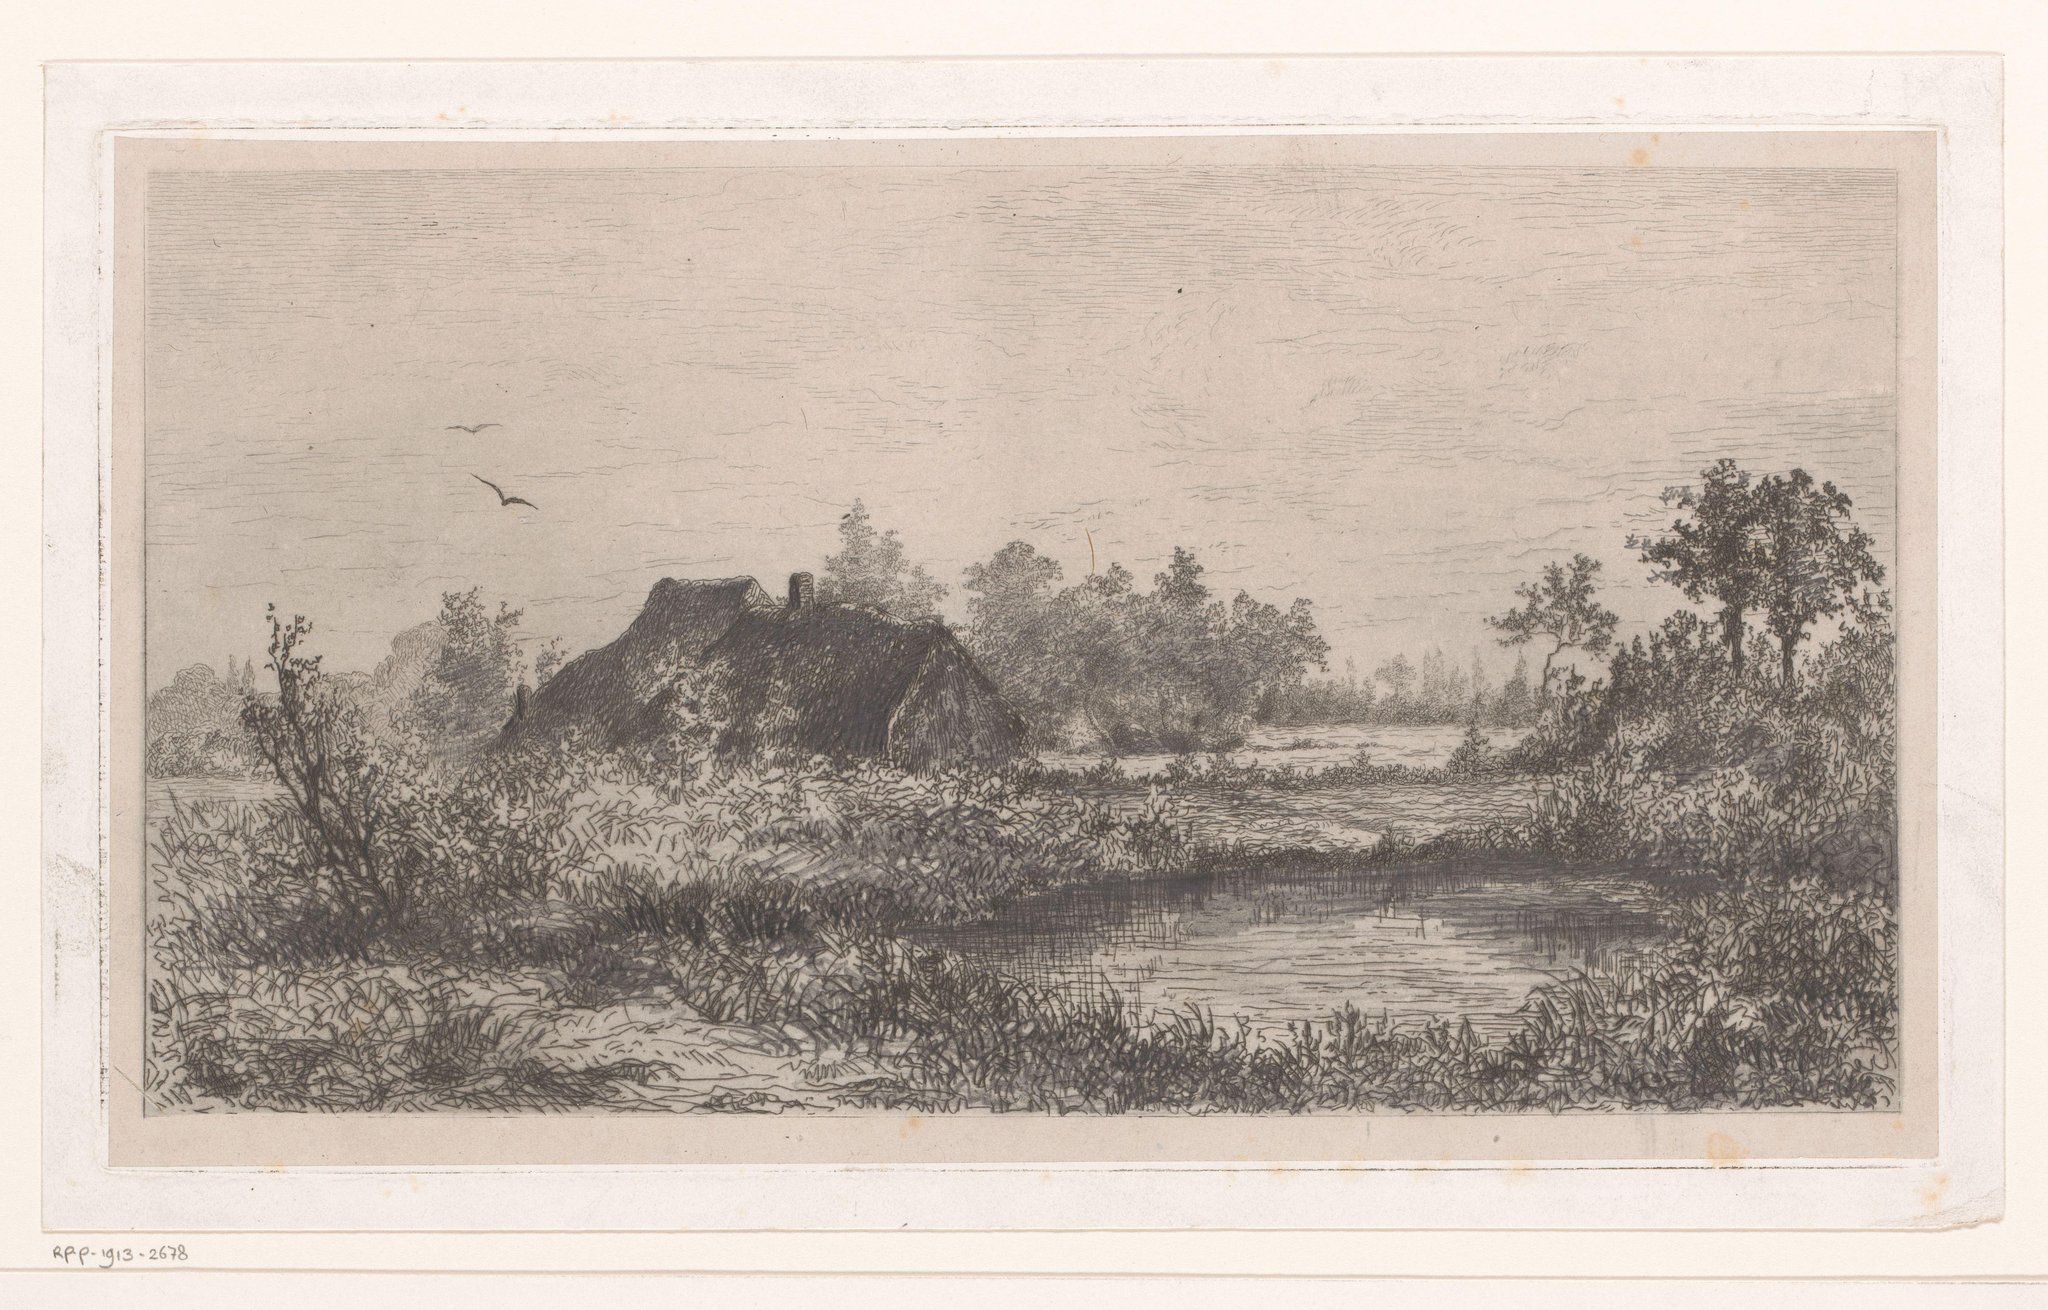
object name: print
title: Boerderij aan een waterplas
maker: emilie rolin-jacquemijns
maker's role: print maker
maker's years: 1842-1906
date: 1852-1906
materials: paper, pencil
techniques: etching, retroussage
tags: pond, pool, farm or solitary house in landscape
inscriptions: collector's mark: Lugt 2228